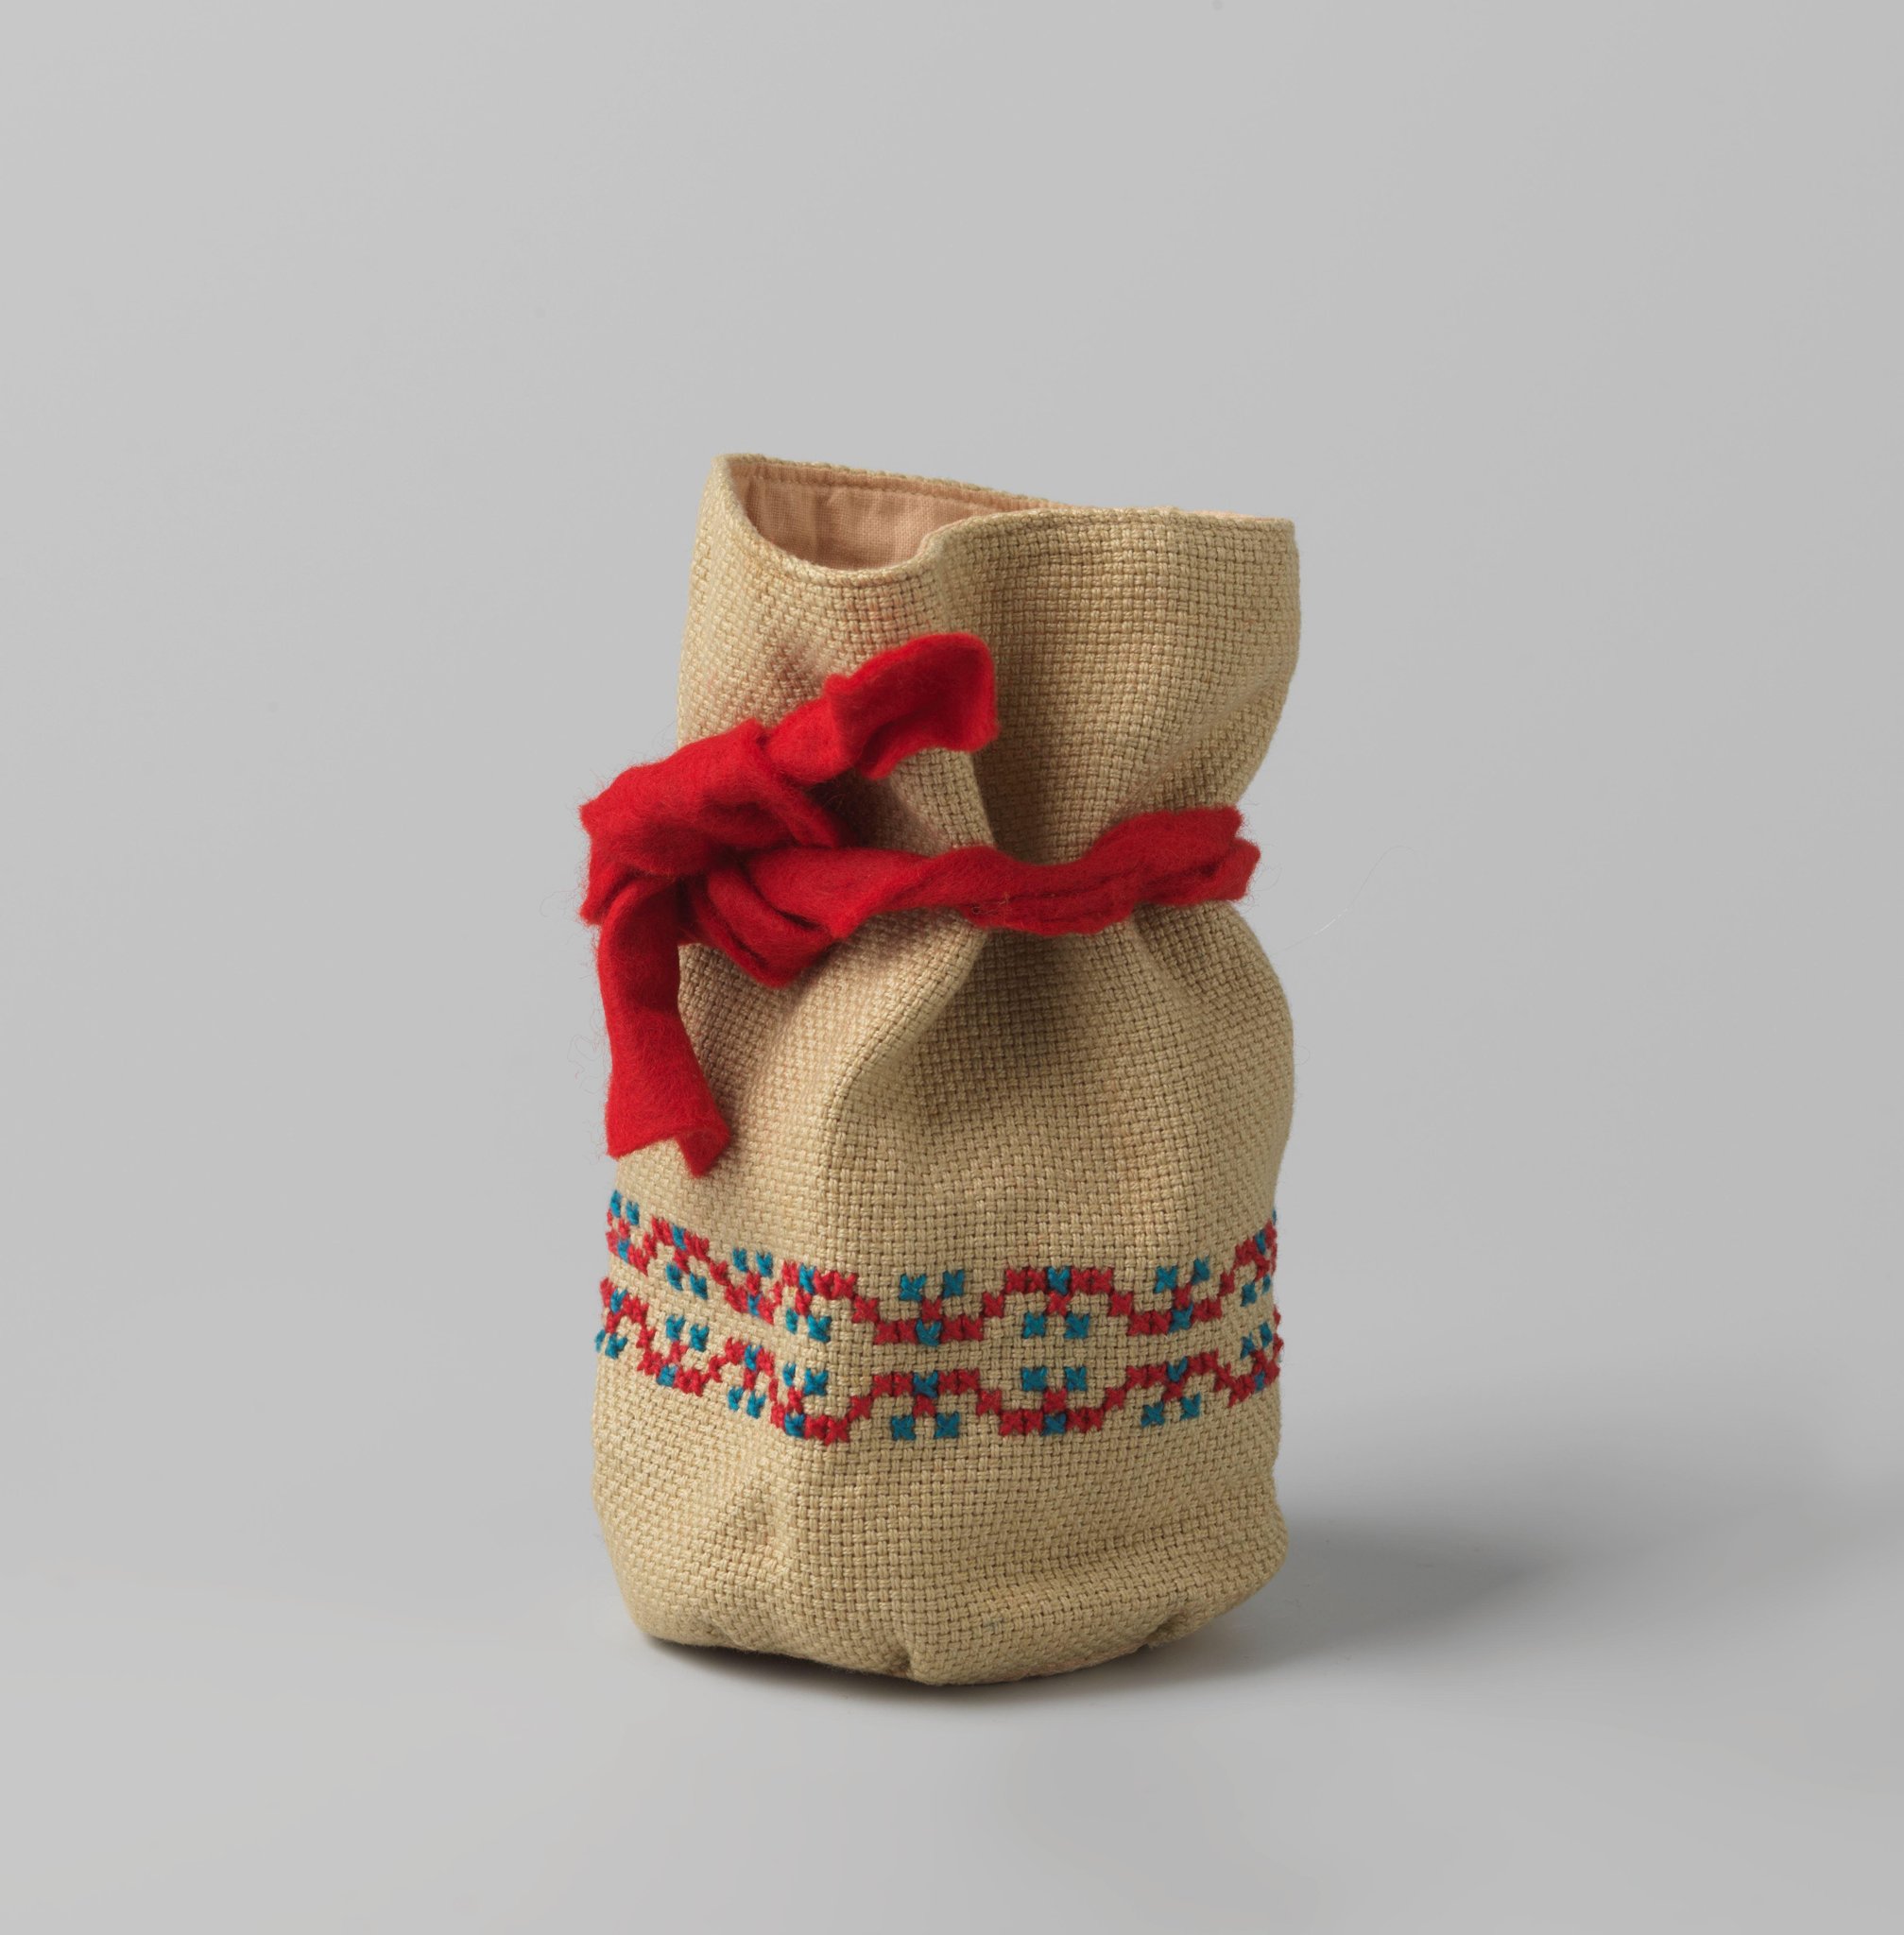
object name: persoonlijk object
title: Geborduurde zak voor toiletartikelen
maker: Anonymous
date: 1910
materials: textile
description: Geborduurde zak met rode strik voor toiletartikelen.